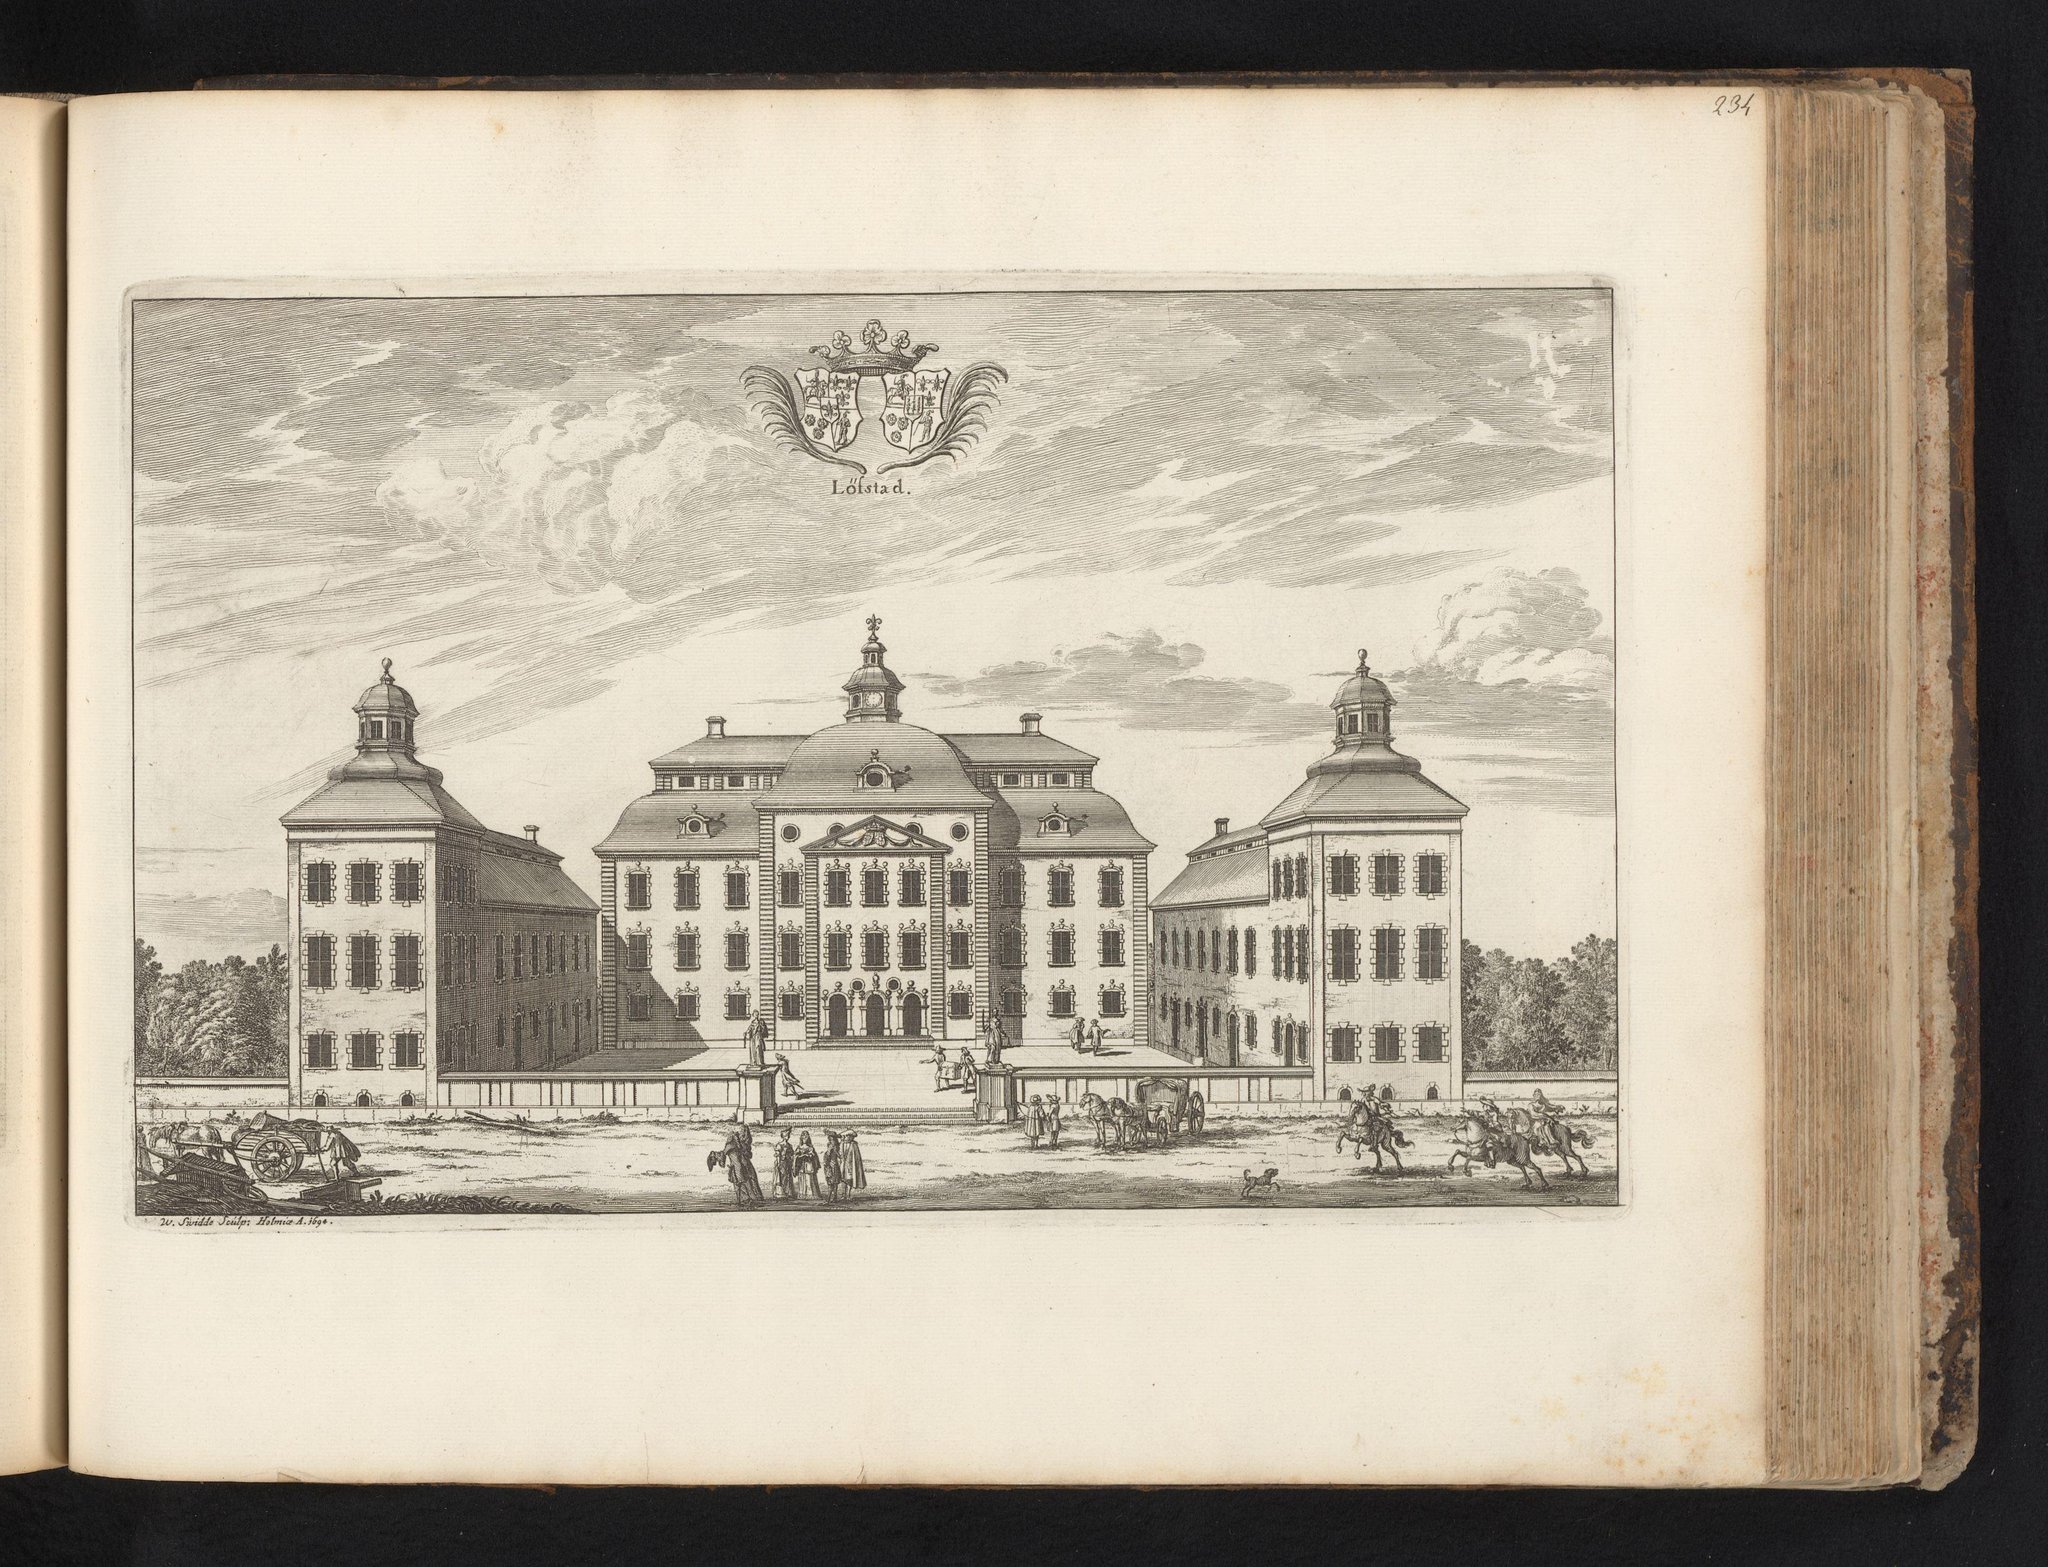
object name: album leaf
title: Gezicht op slot Löfstad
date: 1690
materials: paper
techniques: etching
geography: stockholm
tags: housing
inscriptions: date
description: Kungliga Biblioteket, 'Suecia': http://www.kb.se/samlingarna/Kartor-bilder/Suecia-antiqua/ (geraadpleegd november 2016).